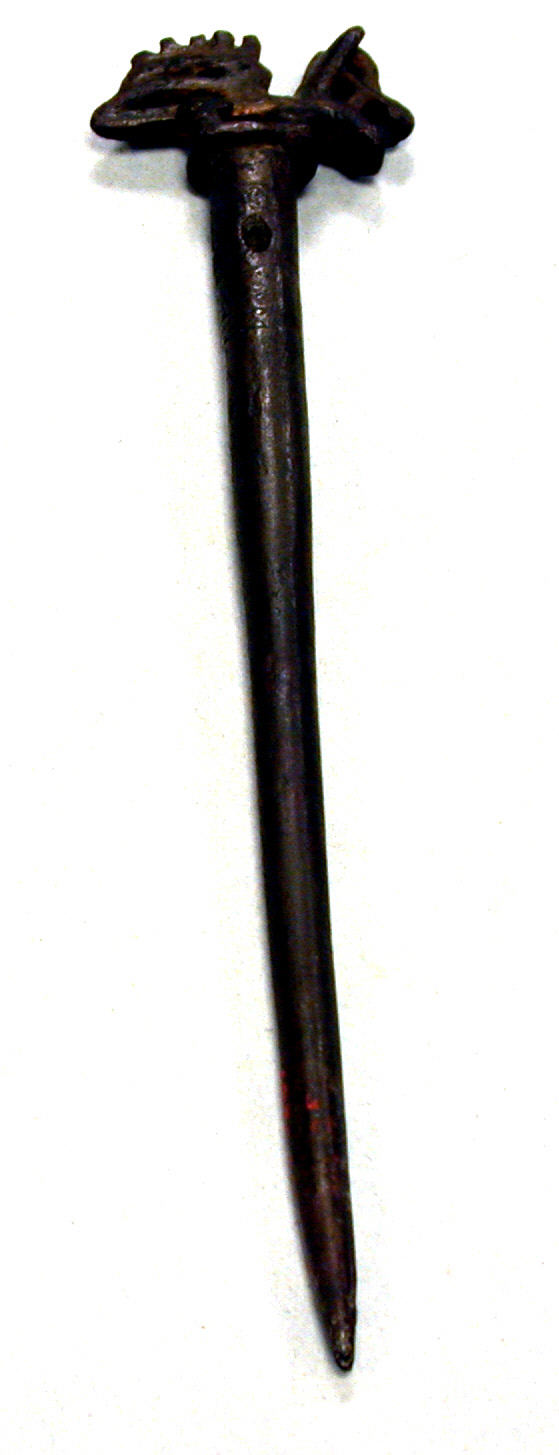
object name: pin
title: Ornamental Pin (Tupu)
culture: inca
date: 1401-1600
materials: bronze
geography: peru